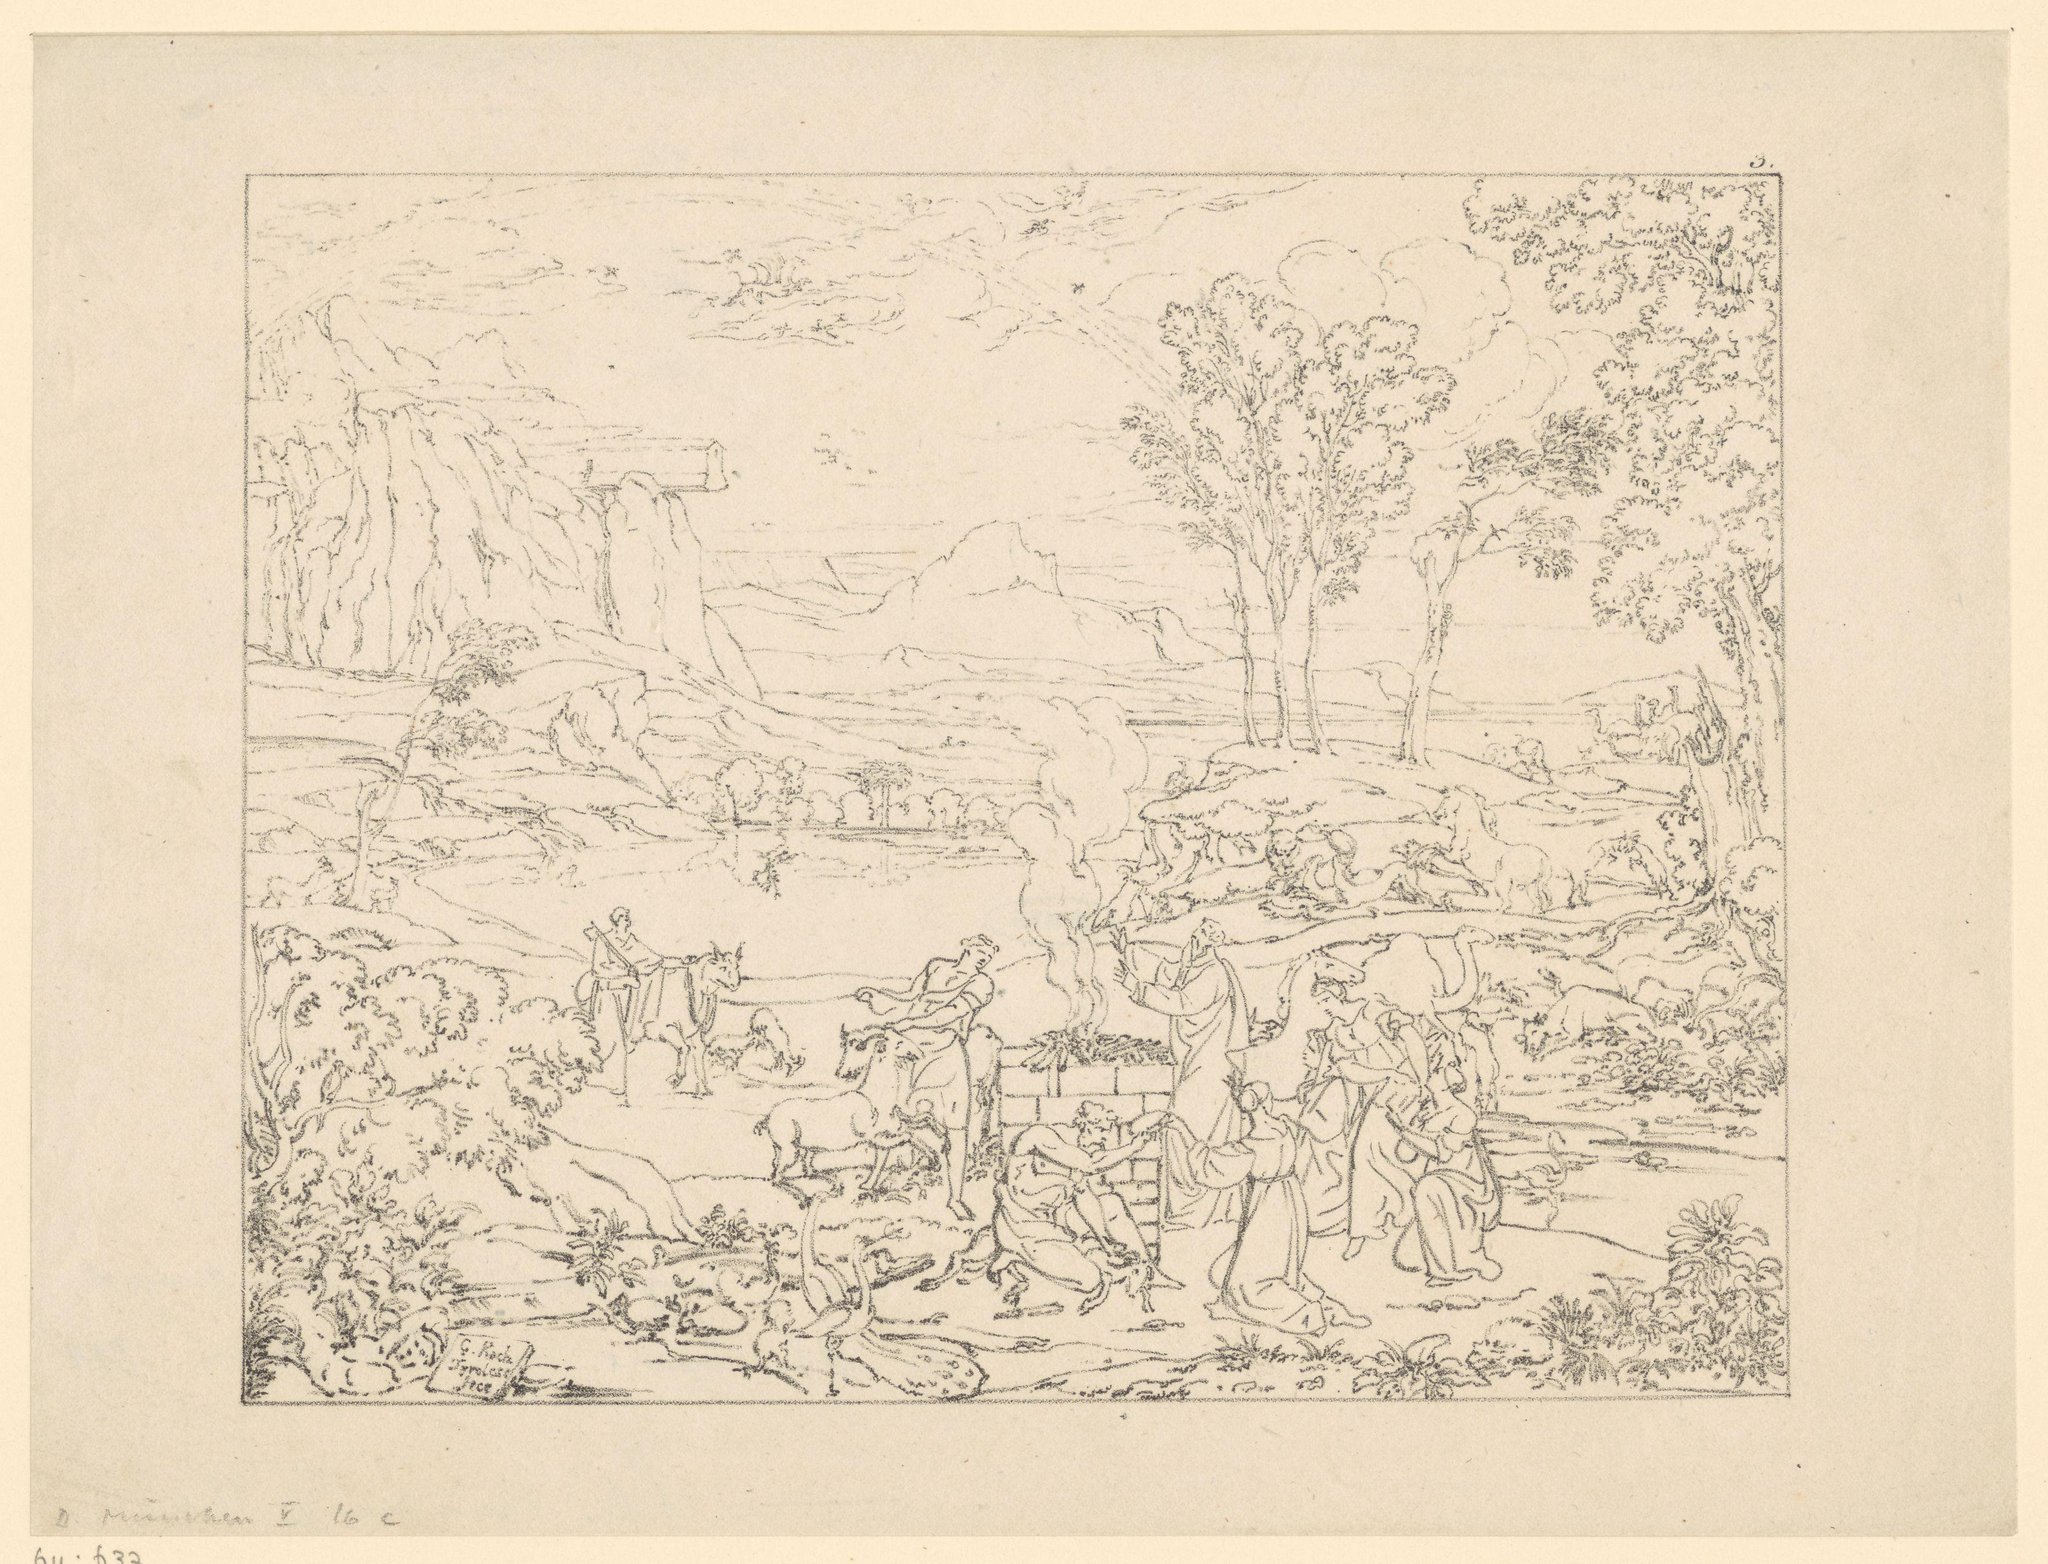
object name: print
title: Dankoffer van Noach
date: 1803-1820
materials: paper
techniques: lithograph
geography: germany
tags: landscapes (+ landscape with figures, staffage), noah's sacrifice; various animals are offered, possibly a lamb, a dove and a ram (often combined with the rainbow of the covenant)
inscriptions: collector's mark: Lugt 2228, mark